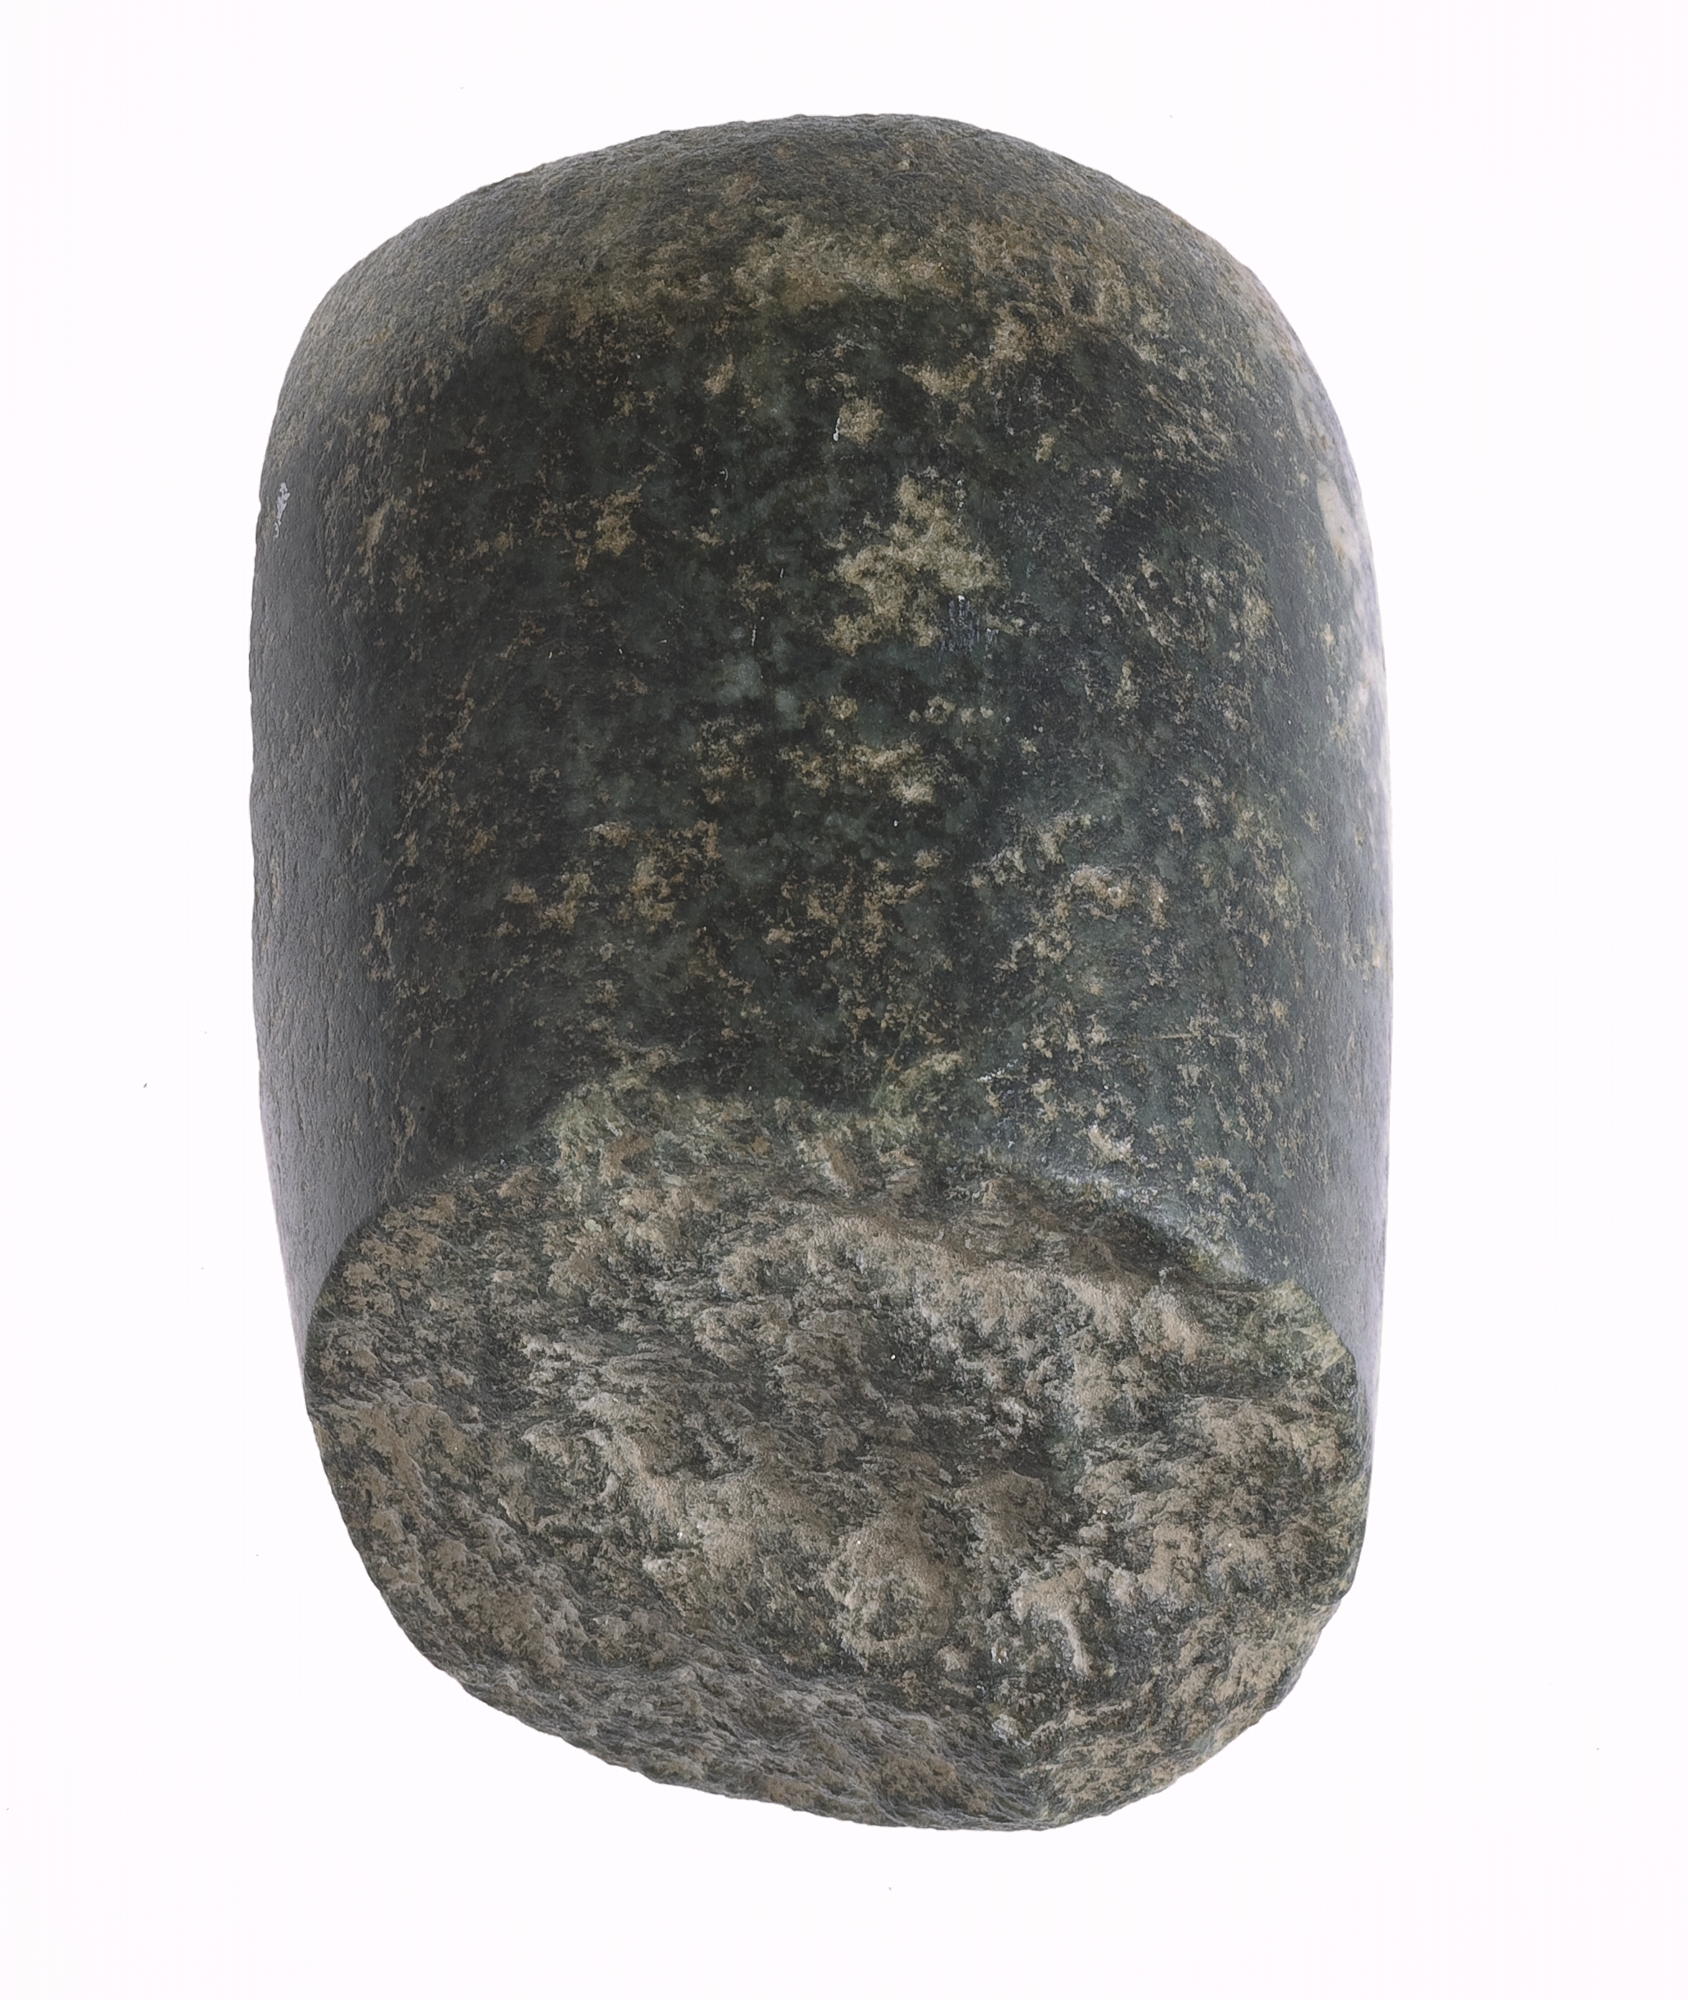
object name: pestle, inscribed object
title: Pestle made from inscribed object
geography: upper egypt, thebes